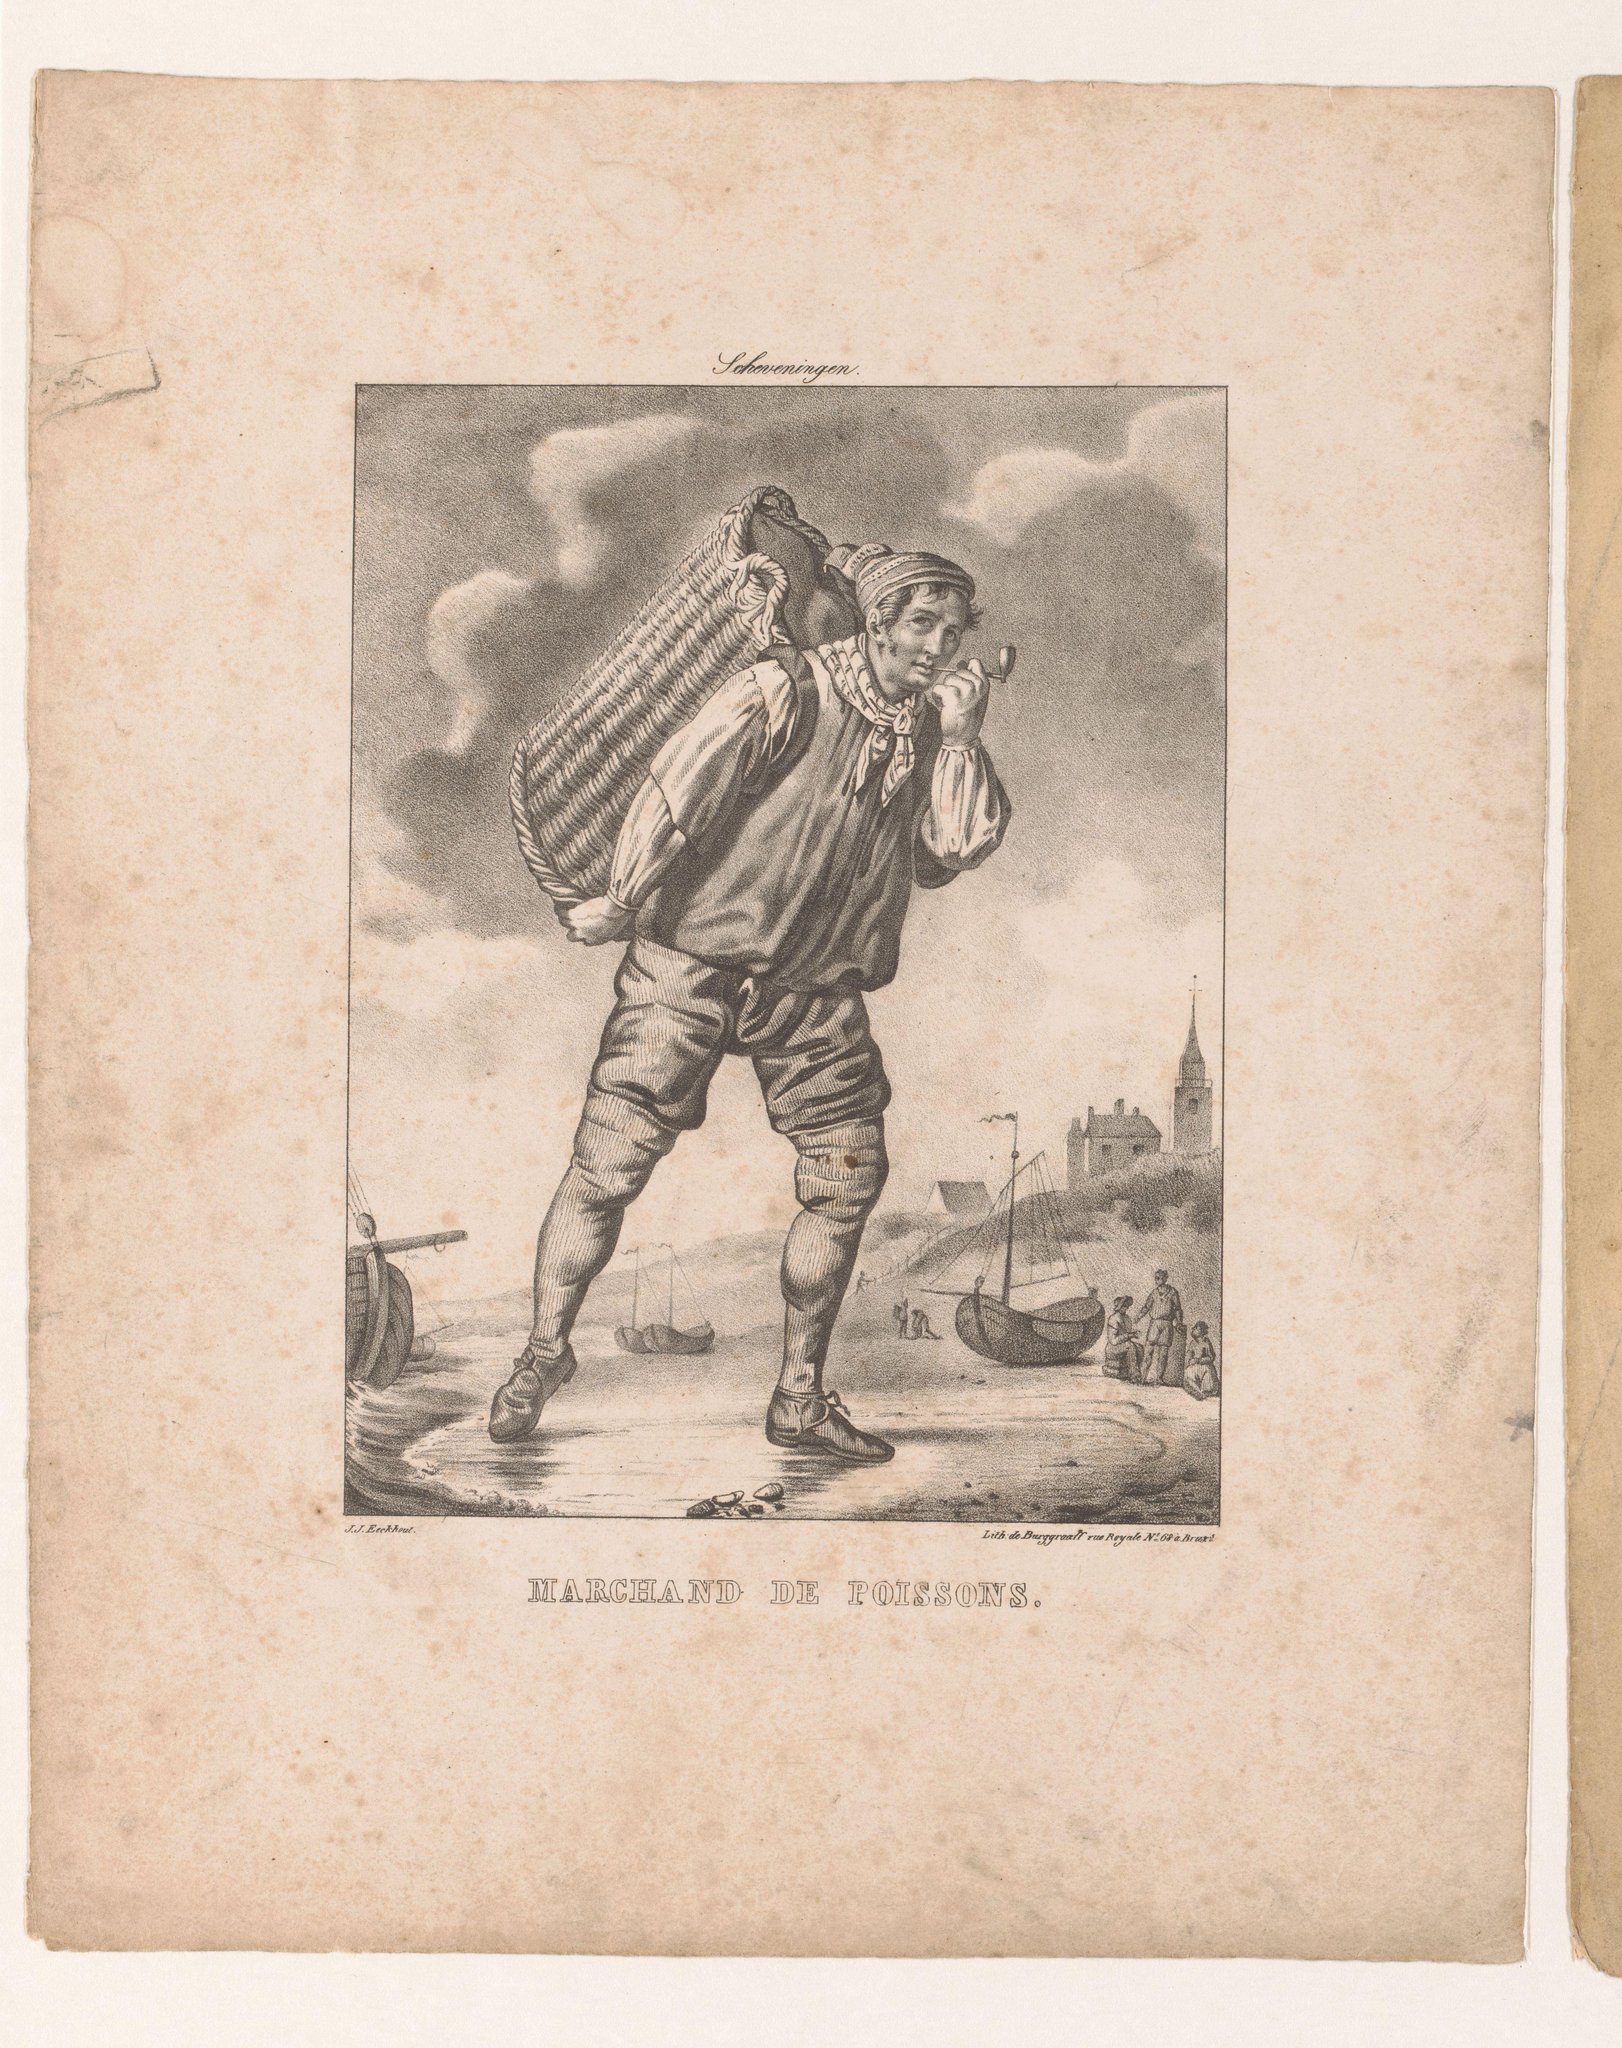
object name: print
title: Visverkoper te Scheveningen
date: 1825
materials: paper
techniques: lithograph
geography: brussels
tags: street-trader (with name of trade or profession), fishes, folk costume, regional costume, beach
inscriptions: collector's mark: Lugt 2228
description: Prent maakt deel uit van een serie van 52 prenten.